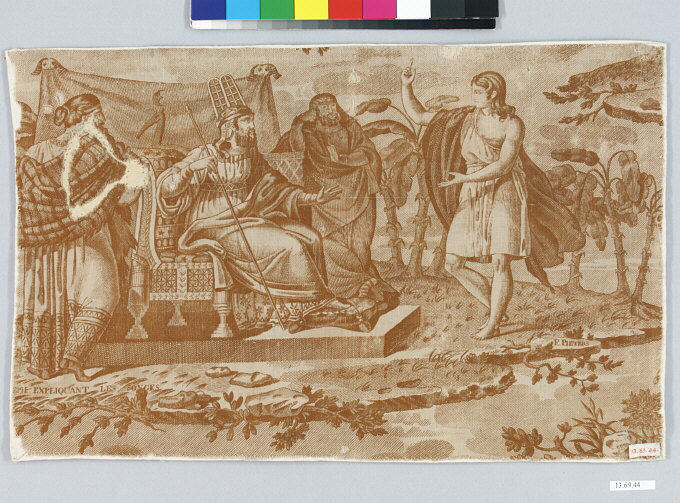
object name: piece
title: Joseph interpreting Pharoah's dreams from the Story of Joseph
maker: f. pieters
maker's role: engraver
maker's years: 1775-1875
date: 1820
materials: cotton